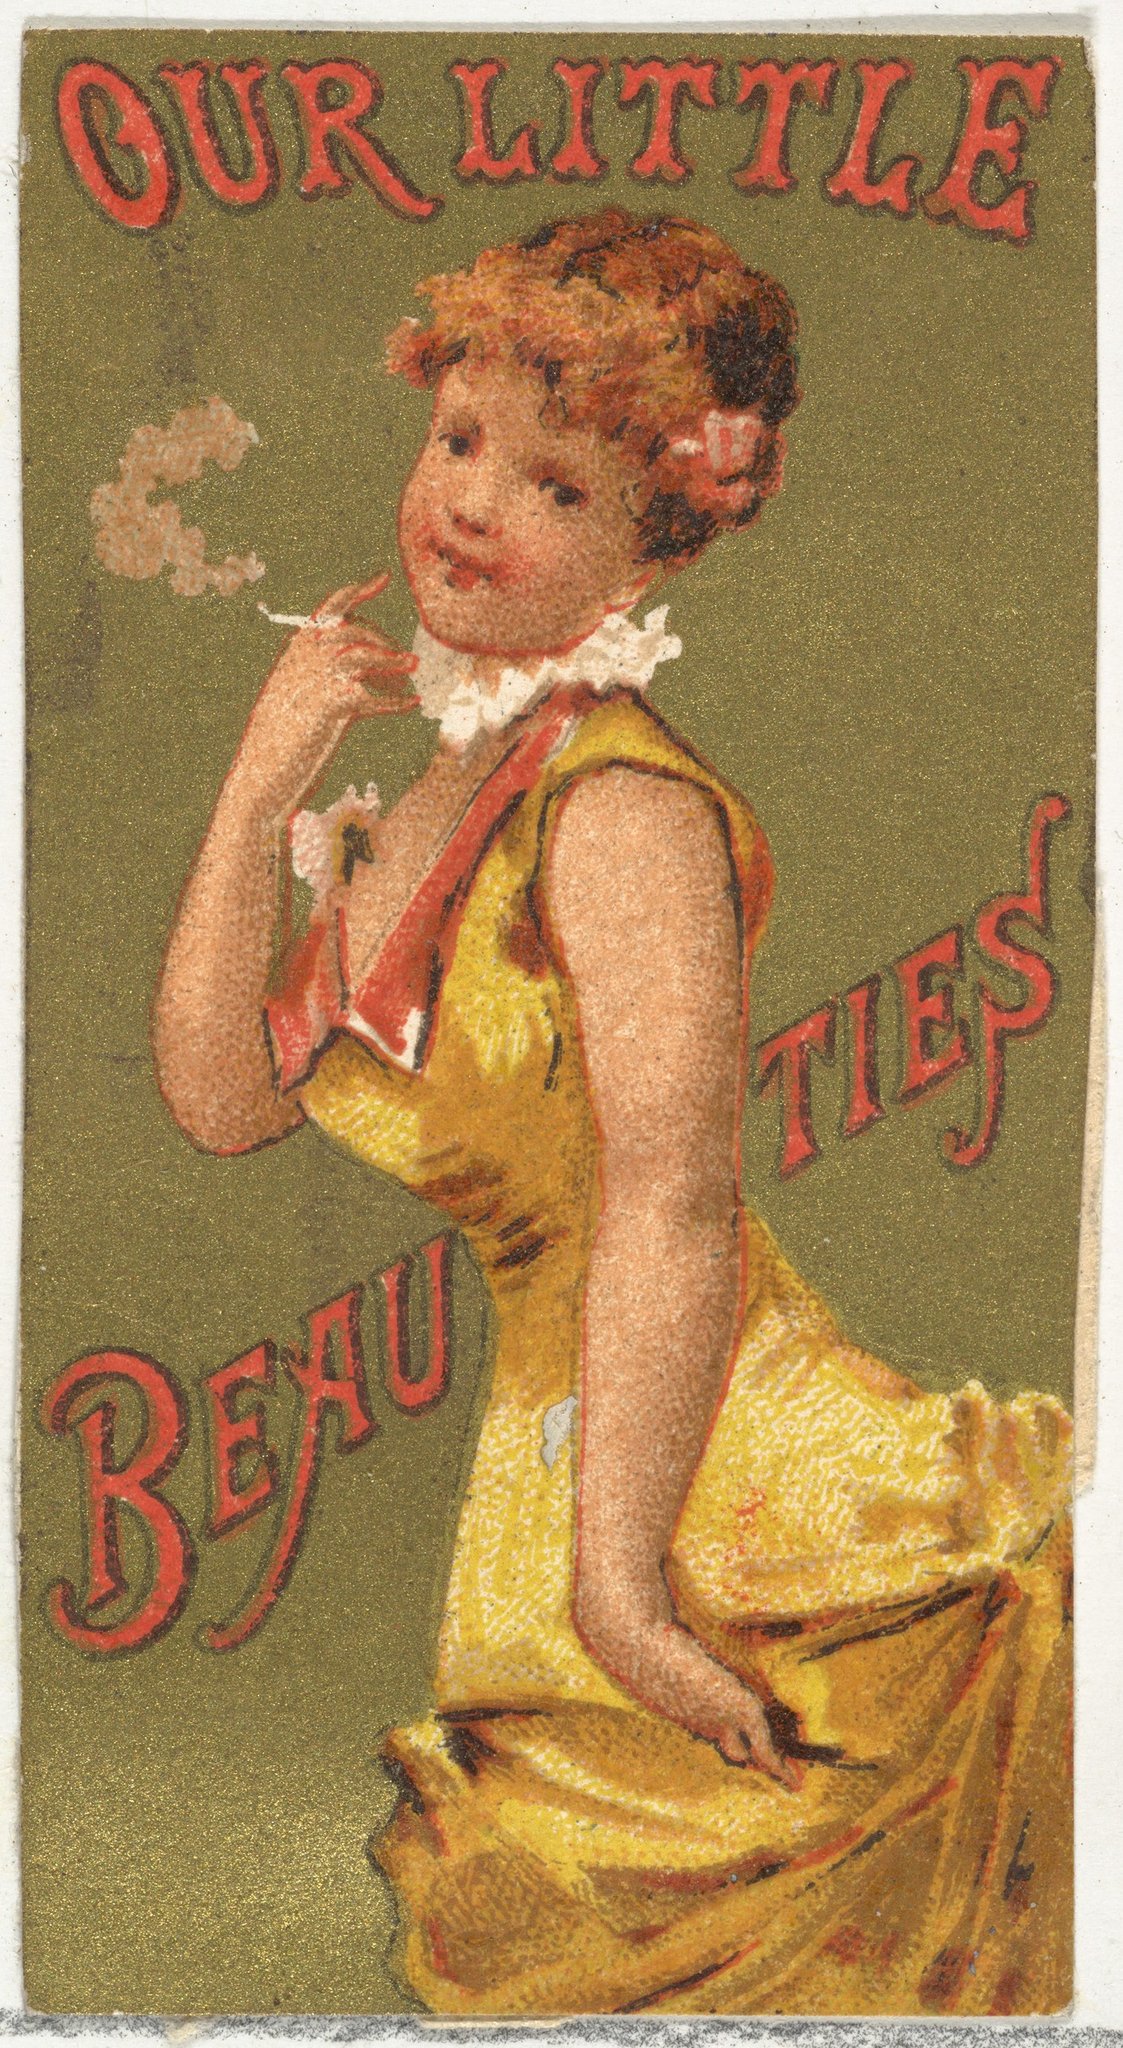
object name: print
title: From the Girls and Children series (N58) promoting Our Little Beauties Cigarettes for Allen & Ginter brand tobacco products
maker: allen & ginter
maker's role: publisher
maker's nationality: american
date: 1887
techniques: color lithograph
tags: girls,smoking